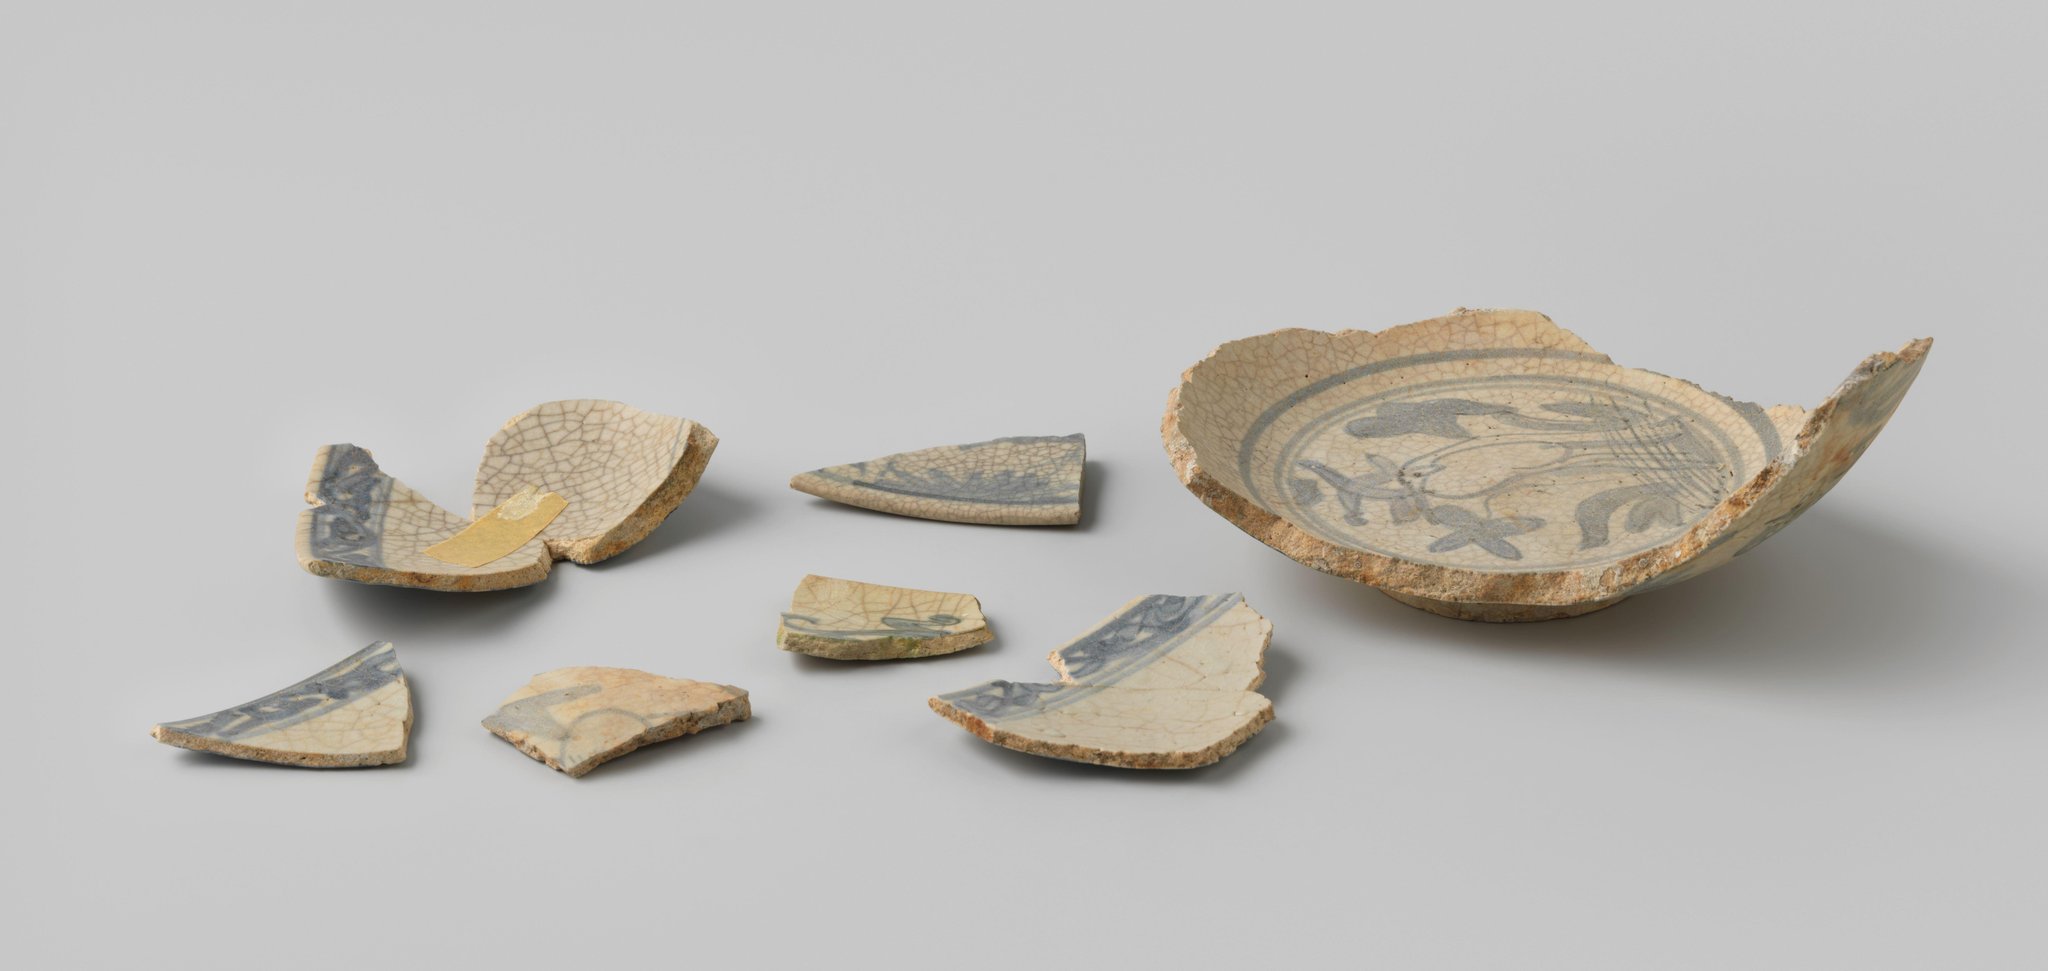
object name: sherd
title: Scherven van een kom uit V.O.C.-schip de 'Witte Leeuw'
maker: Anonymous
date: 1613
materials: porcelain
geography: shantou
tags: verenigde oostindische compagnie, sint-helena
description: A bowl. In the centre there is a standing crane among grass. Around the lip-rim a sketchy design of leaves. On the outside a pond landscape, 4 groups of ducks are drawn, one under the other, with a large lotus leaf and pond weeds in between.